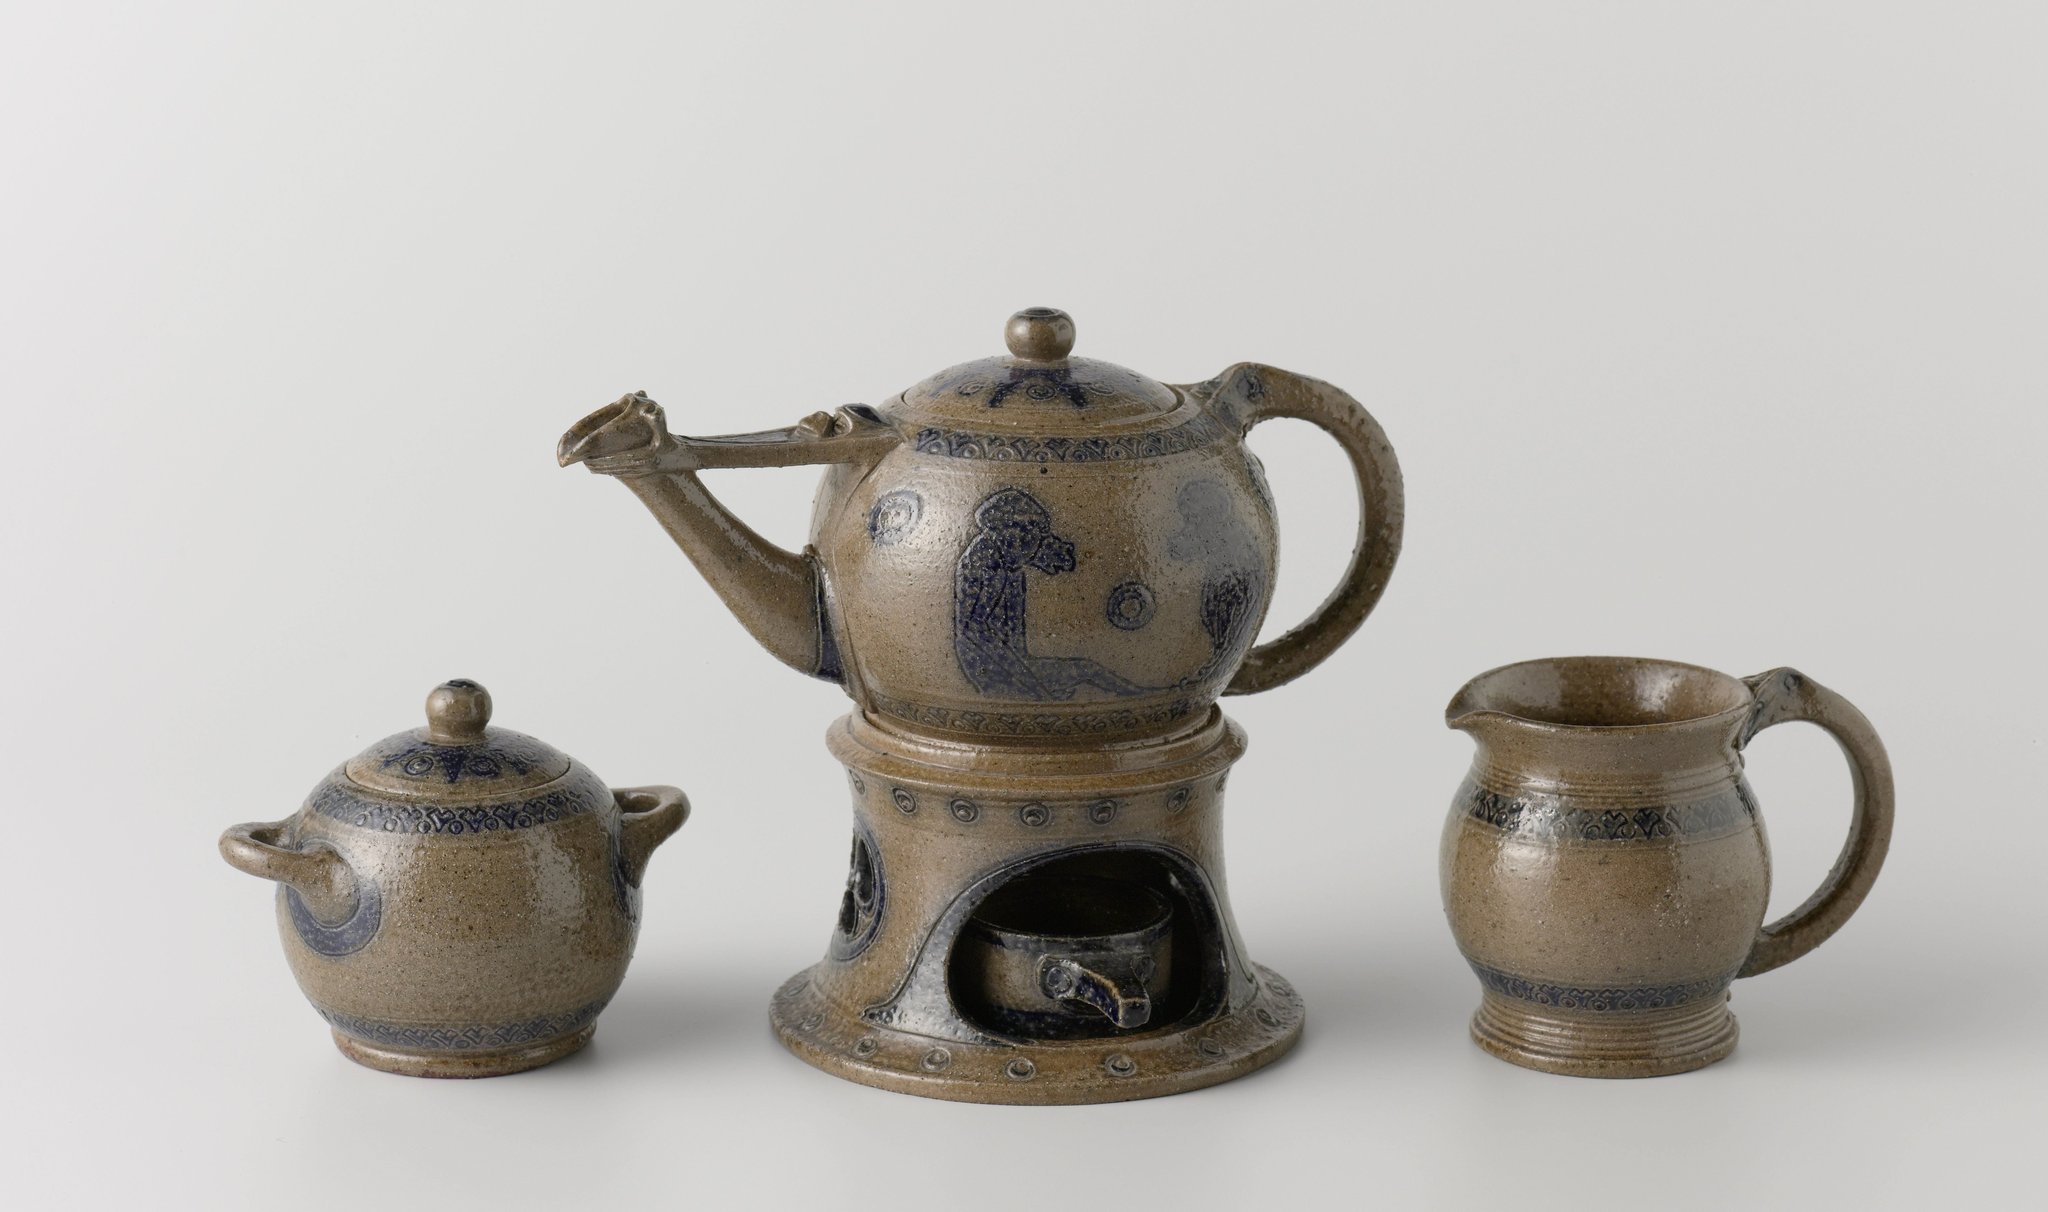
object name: tea service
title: Theeservies van steengoed met zoutglazuur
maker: joseph mendes da costa (1863-1939)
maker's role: print maker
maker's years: 1863-1939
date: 1901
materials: stoneware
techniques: firing, vitrification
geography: amsterdam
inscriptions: date: ‘1901’, maker's mark: ‘JMD’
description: Theeservies van steengoed met zoutglazuur, bestaande uit een theepot, komfoor, bak, melkkan en suikerpot